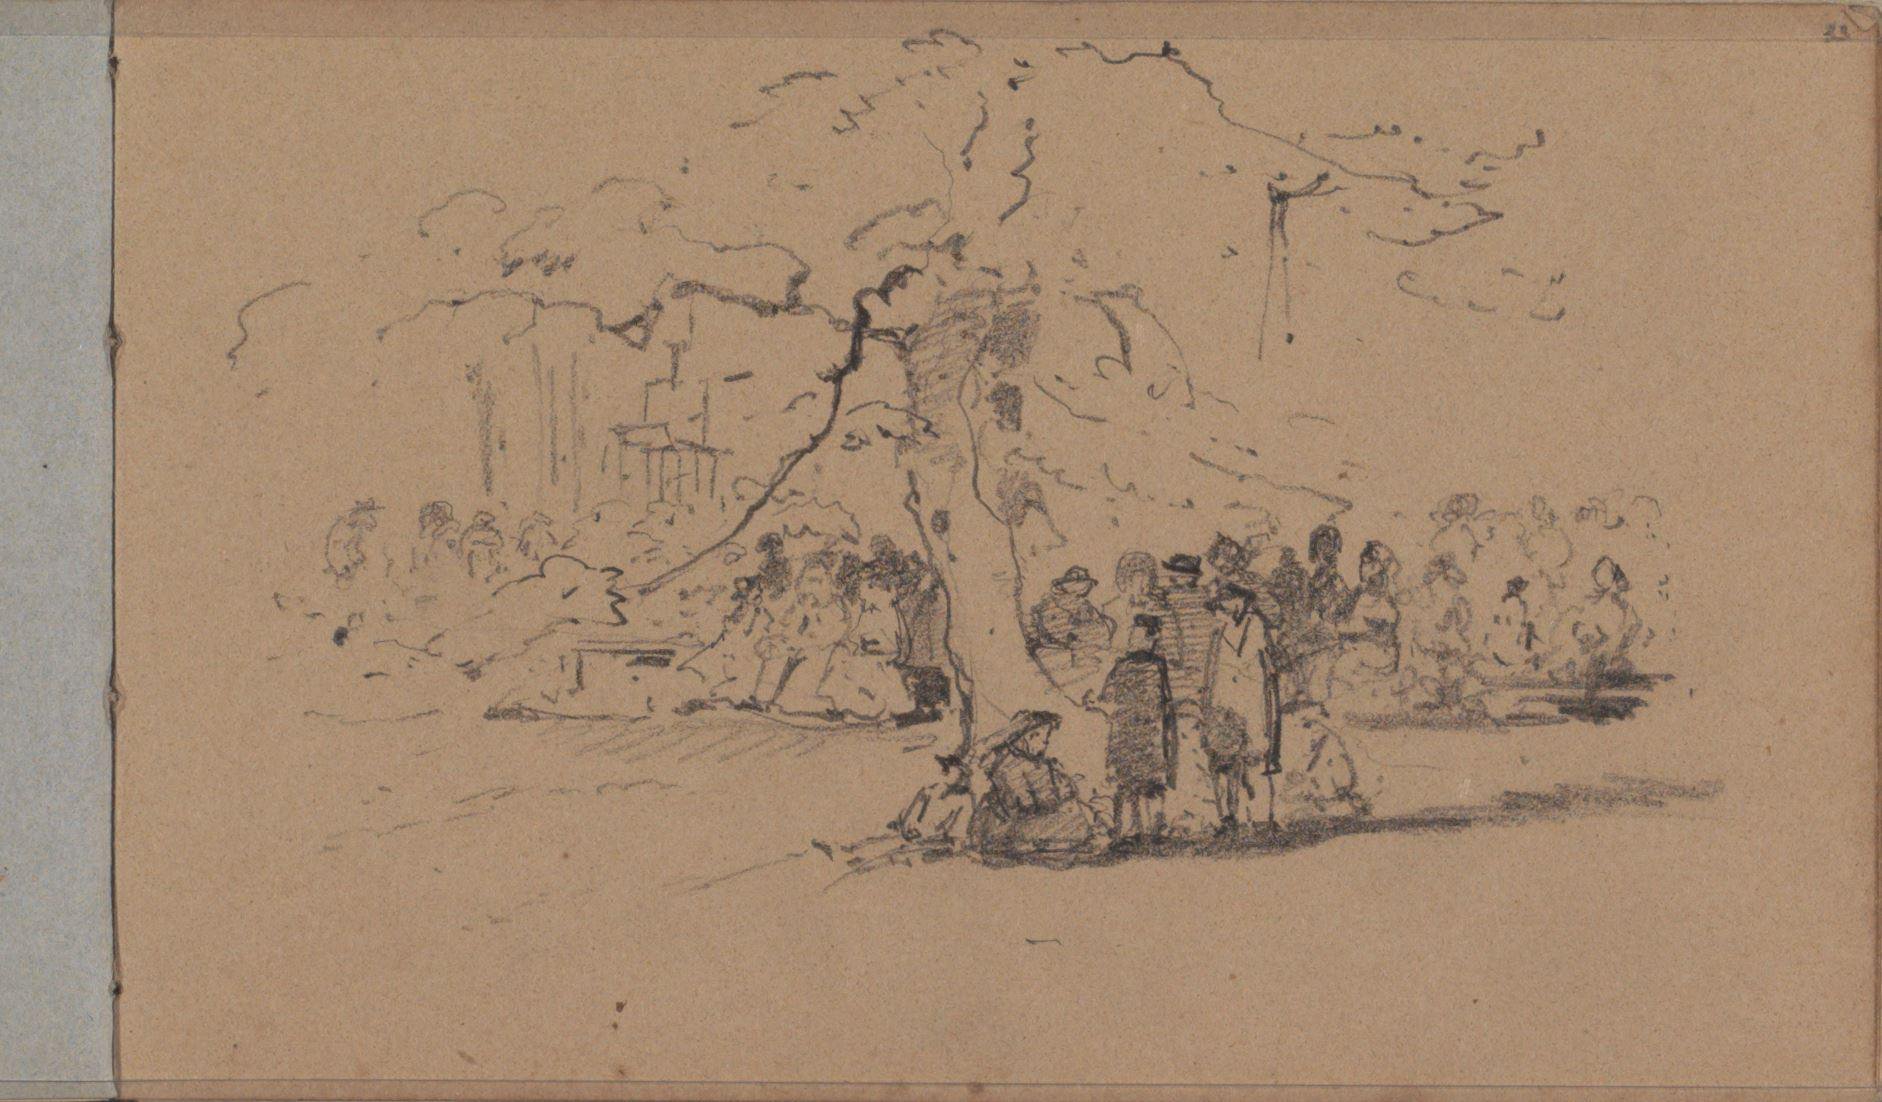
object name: sketchbook leaf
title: Staande en zittende figuren rondom een boom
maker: maria vos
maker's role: draughtsman, painter, print maker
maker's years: 1824-1906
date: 1863-1864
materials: paper, pencil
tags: standing figure, trees, sitting figure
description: Blad 33 recto uit een schetsboek met 41 bladen.